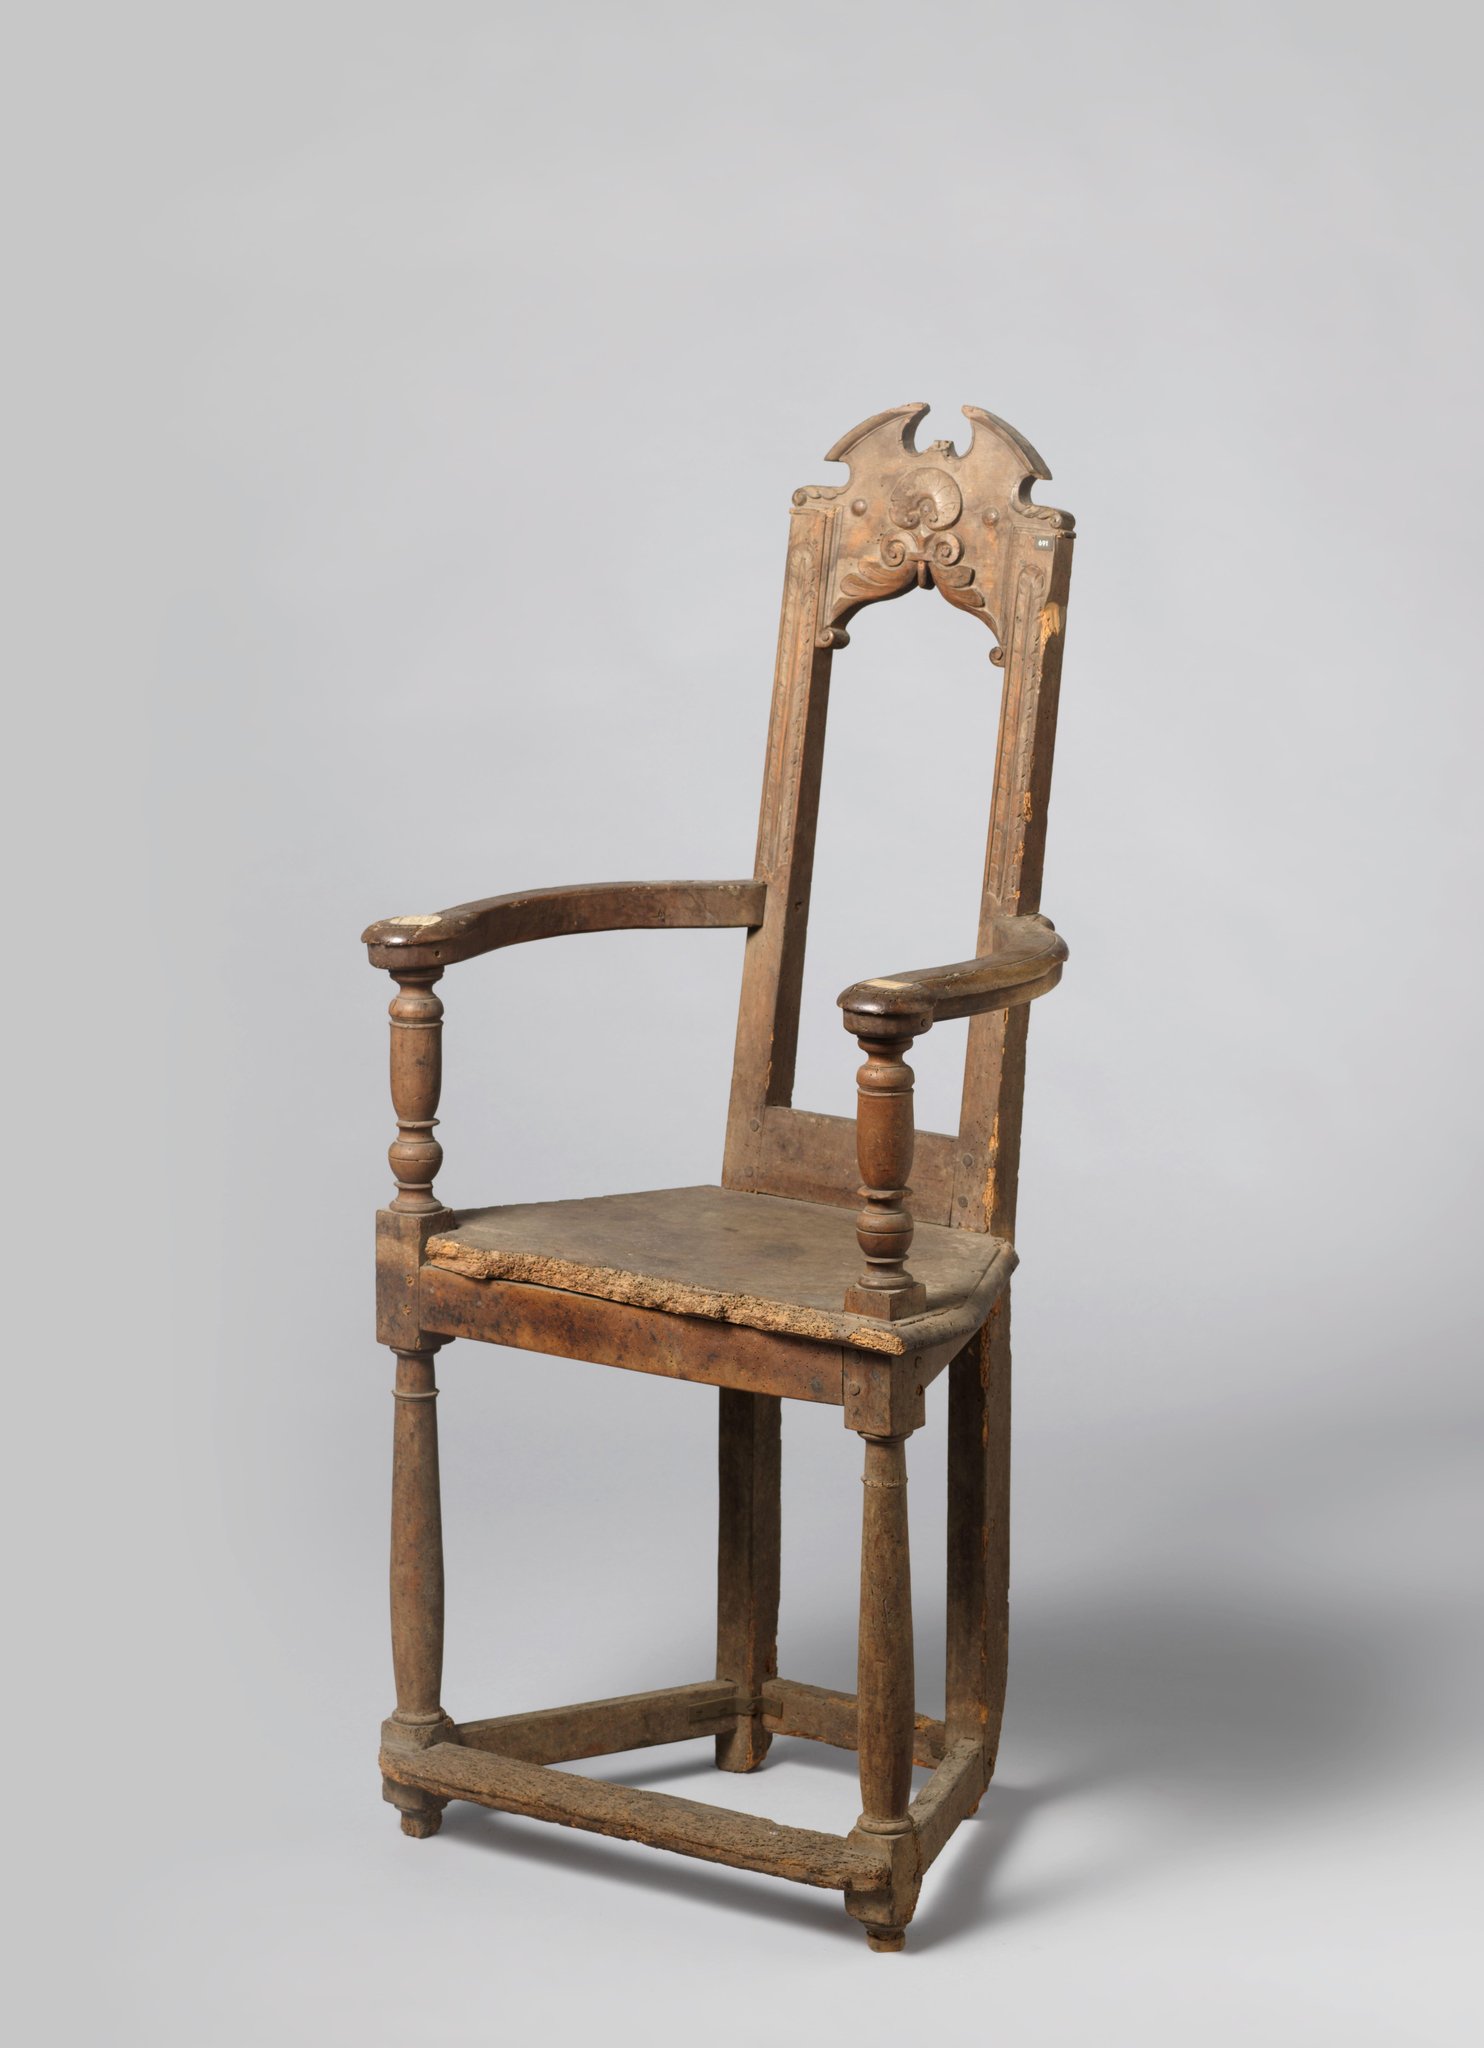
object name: armchair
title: Armstoel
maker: Anonymous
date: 1550-1600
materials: wood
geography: france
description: Armstoel van notenhout (z.g. caquetoire). De voorpoten zijn zuilvormig. De poten worden aan de onderkant door regels verbonden. Het trapeziumvormige zitraam heeft een aan de zijkanten flauw gebogen zitblad; de vorm van de vier armleggers, met vaasvormige geledingen, en de smallere afstand tussen de achterpoot corresponderen hiermee. De rug heeft een vlak gestoken paneel met moresken en draagt bovenop een schelp met vaasvormige bekroning temidden van toegewende bladvoluten. De rugstijlen zijn gecanneleerd.